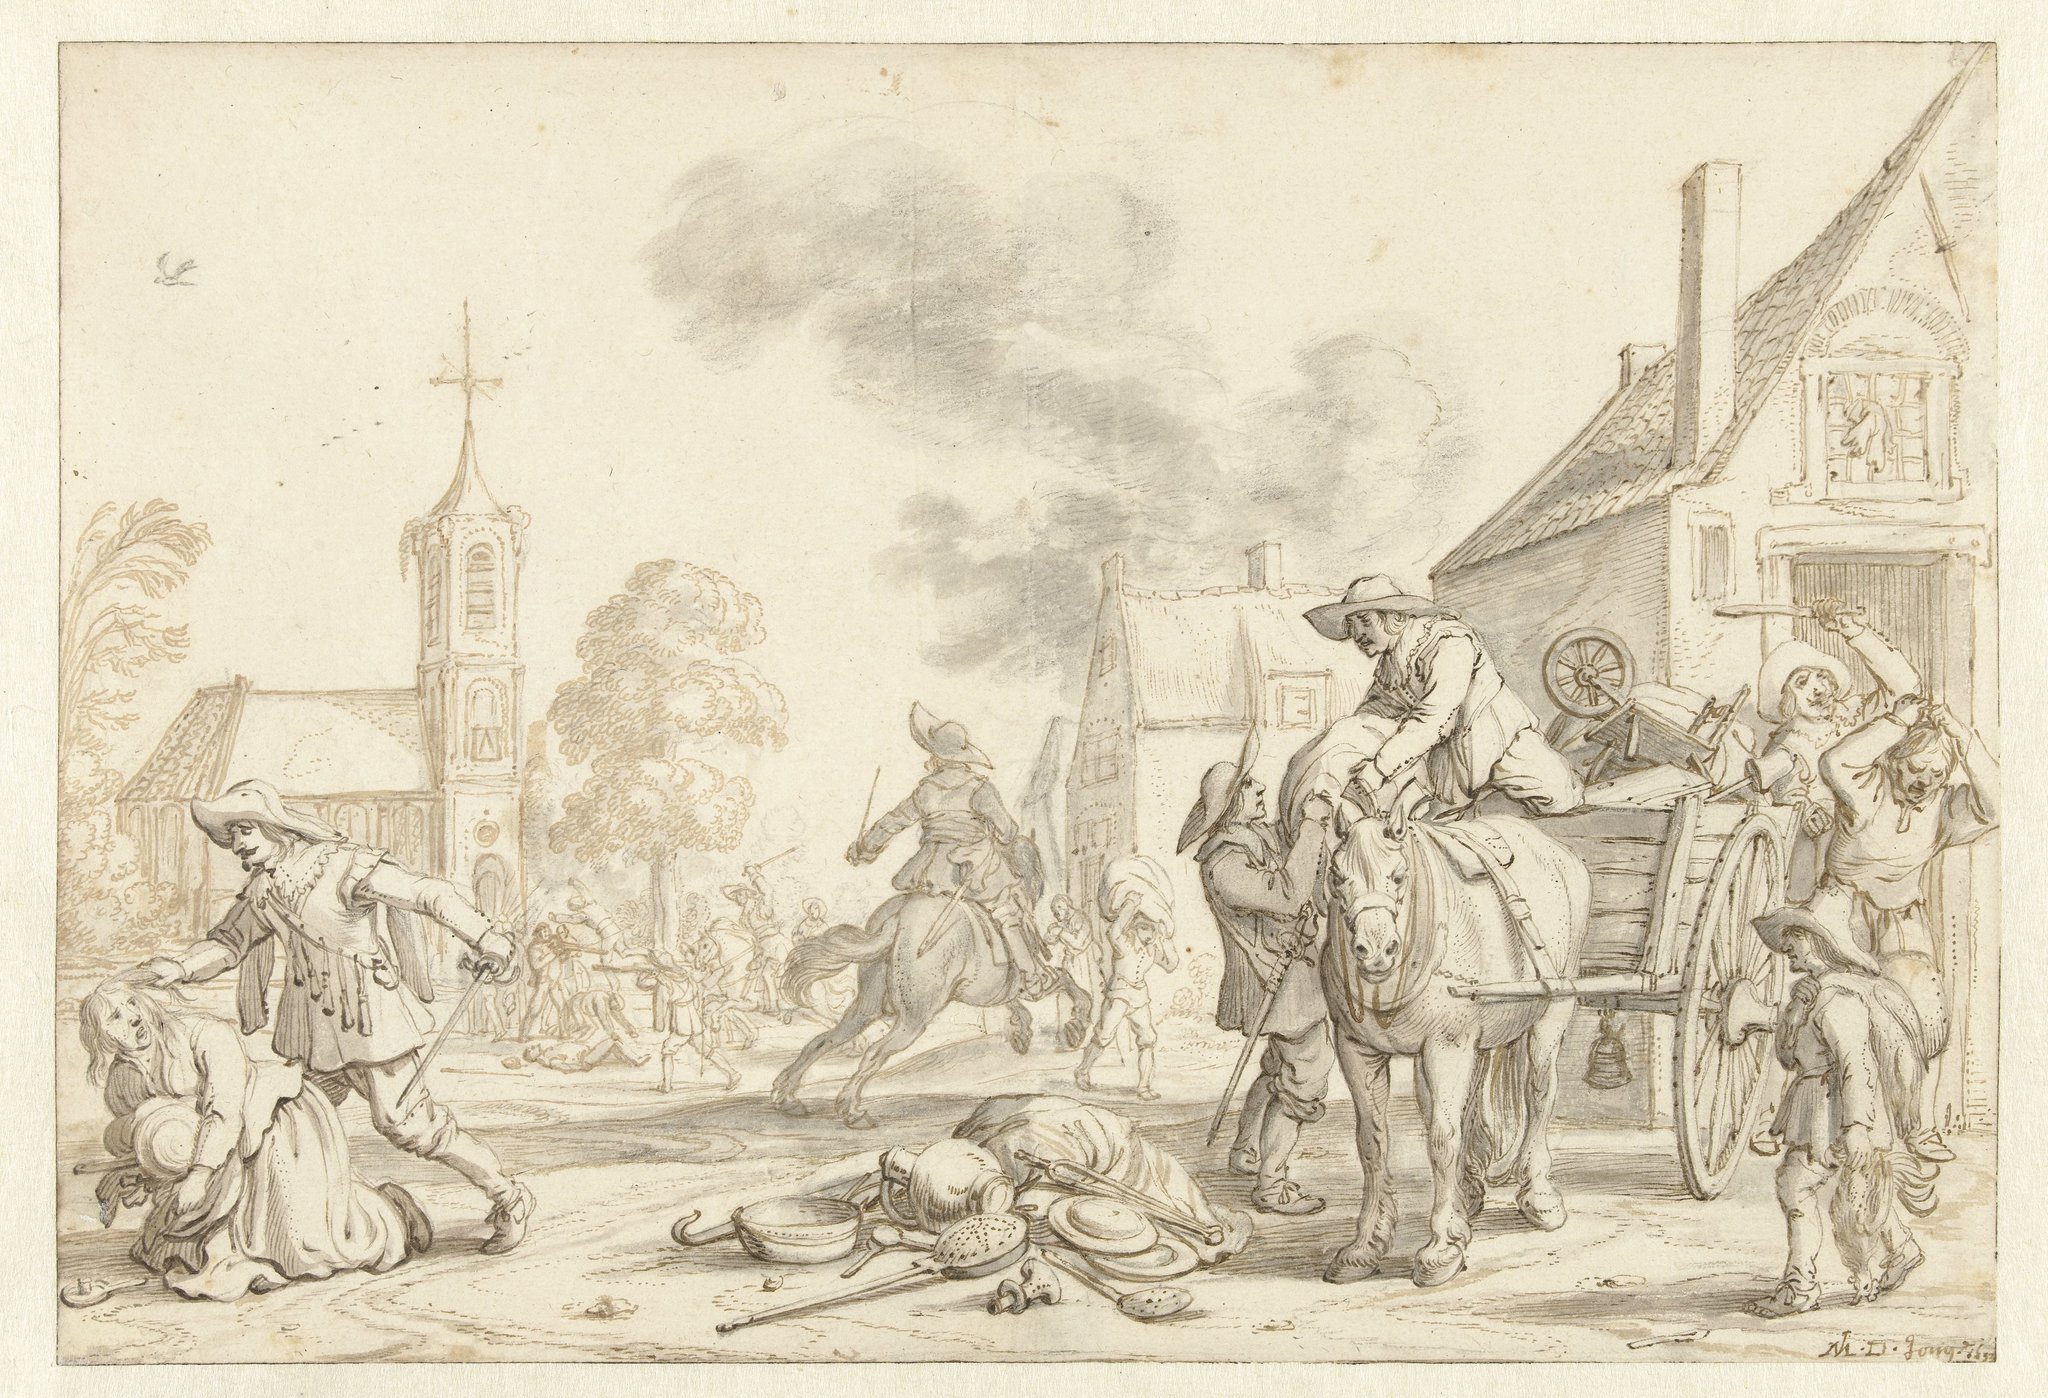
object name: drawing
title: Soldaten plunderen een dorp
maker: jan martszen de jonge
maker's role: draughtsman, painter, print maker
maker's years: 1609-1647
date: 1633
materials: chalk, ink, paper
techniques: brush, pen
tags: plundering ~ soldiers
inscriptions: date: ‘1633’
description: Pendant van "Rokende, drinkende en kaartspelende soldaten bij een herberg buiten de stad", inv. nr. RP-T-1901-A-4494.